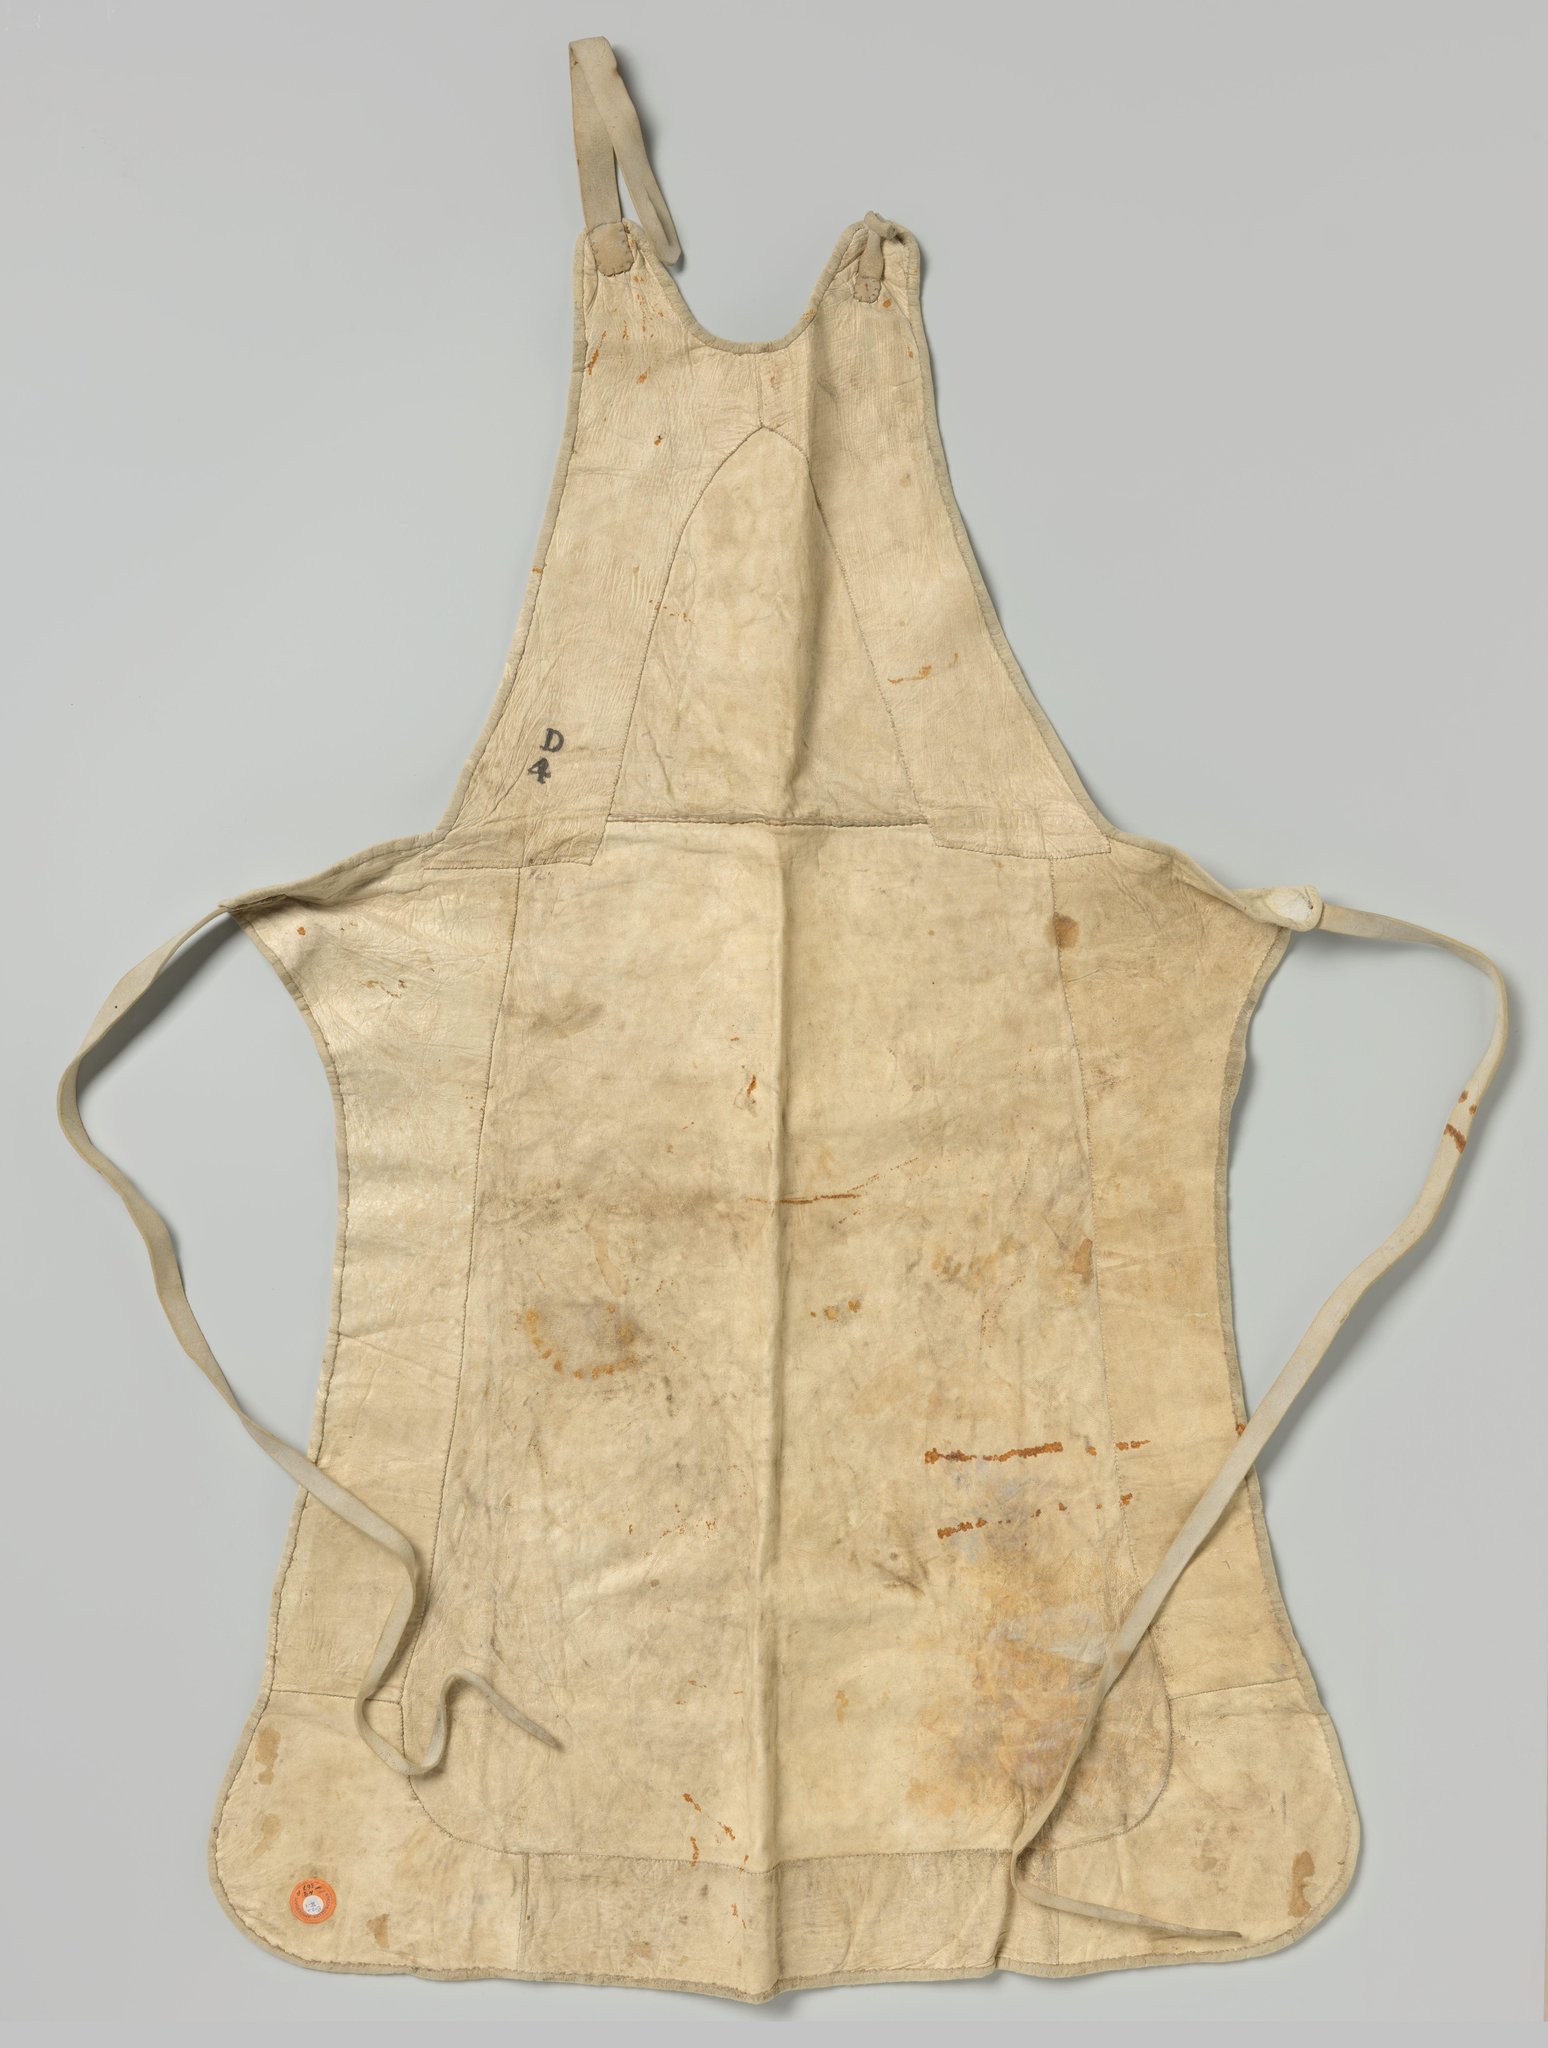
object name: voorschoot, schoot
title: Leren schootsvel behorend tot de uitrusting van een sappeur van de 1e Afdeling Noord-Hollandse Schutterij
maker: Anonymous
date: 1800-1830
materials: leather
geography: netherlands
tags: noord-hollandse schutterij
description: Wit kalfsleren schootsvel. Afkomstig van de uitrusting van een sappeur van de 1e Afdeling Noord-Hollandse Schutterij.